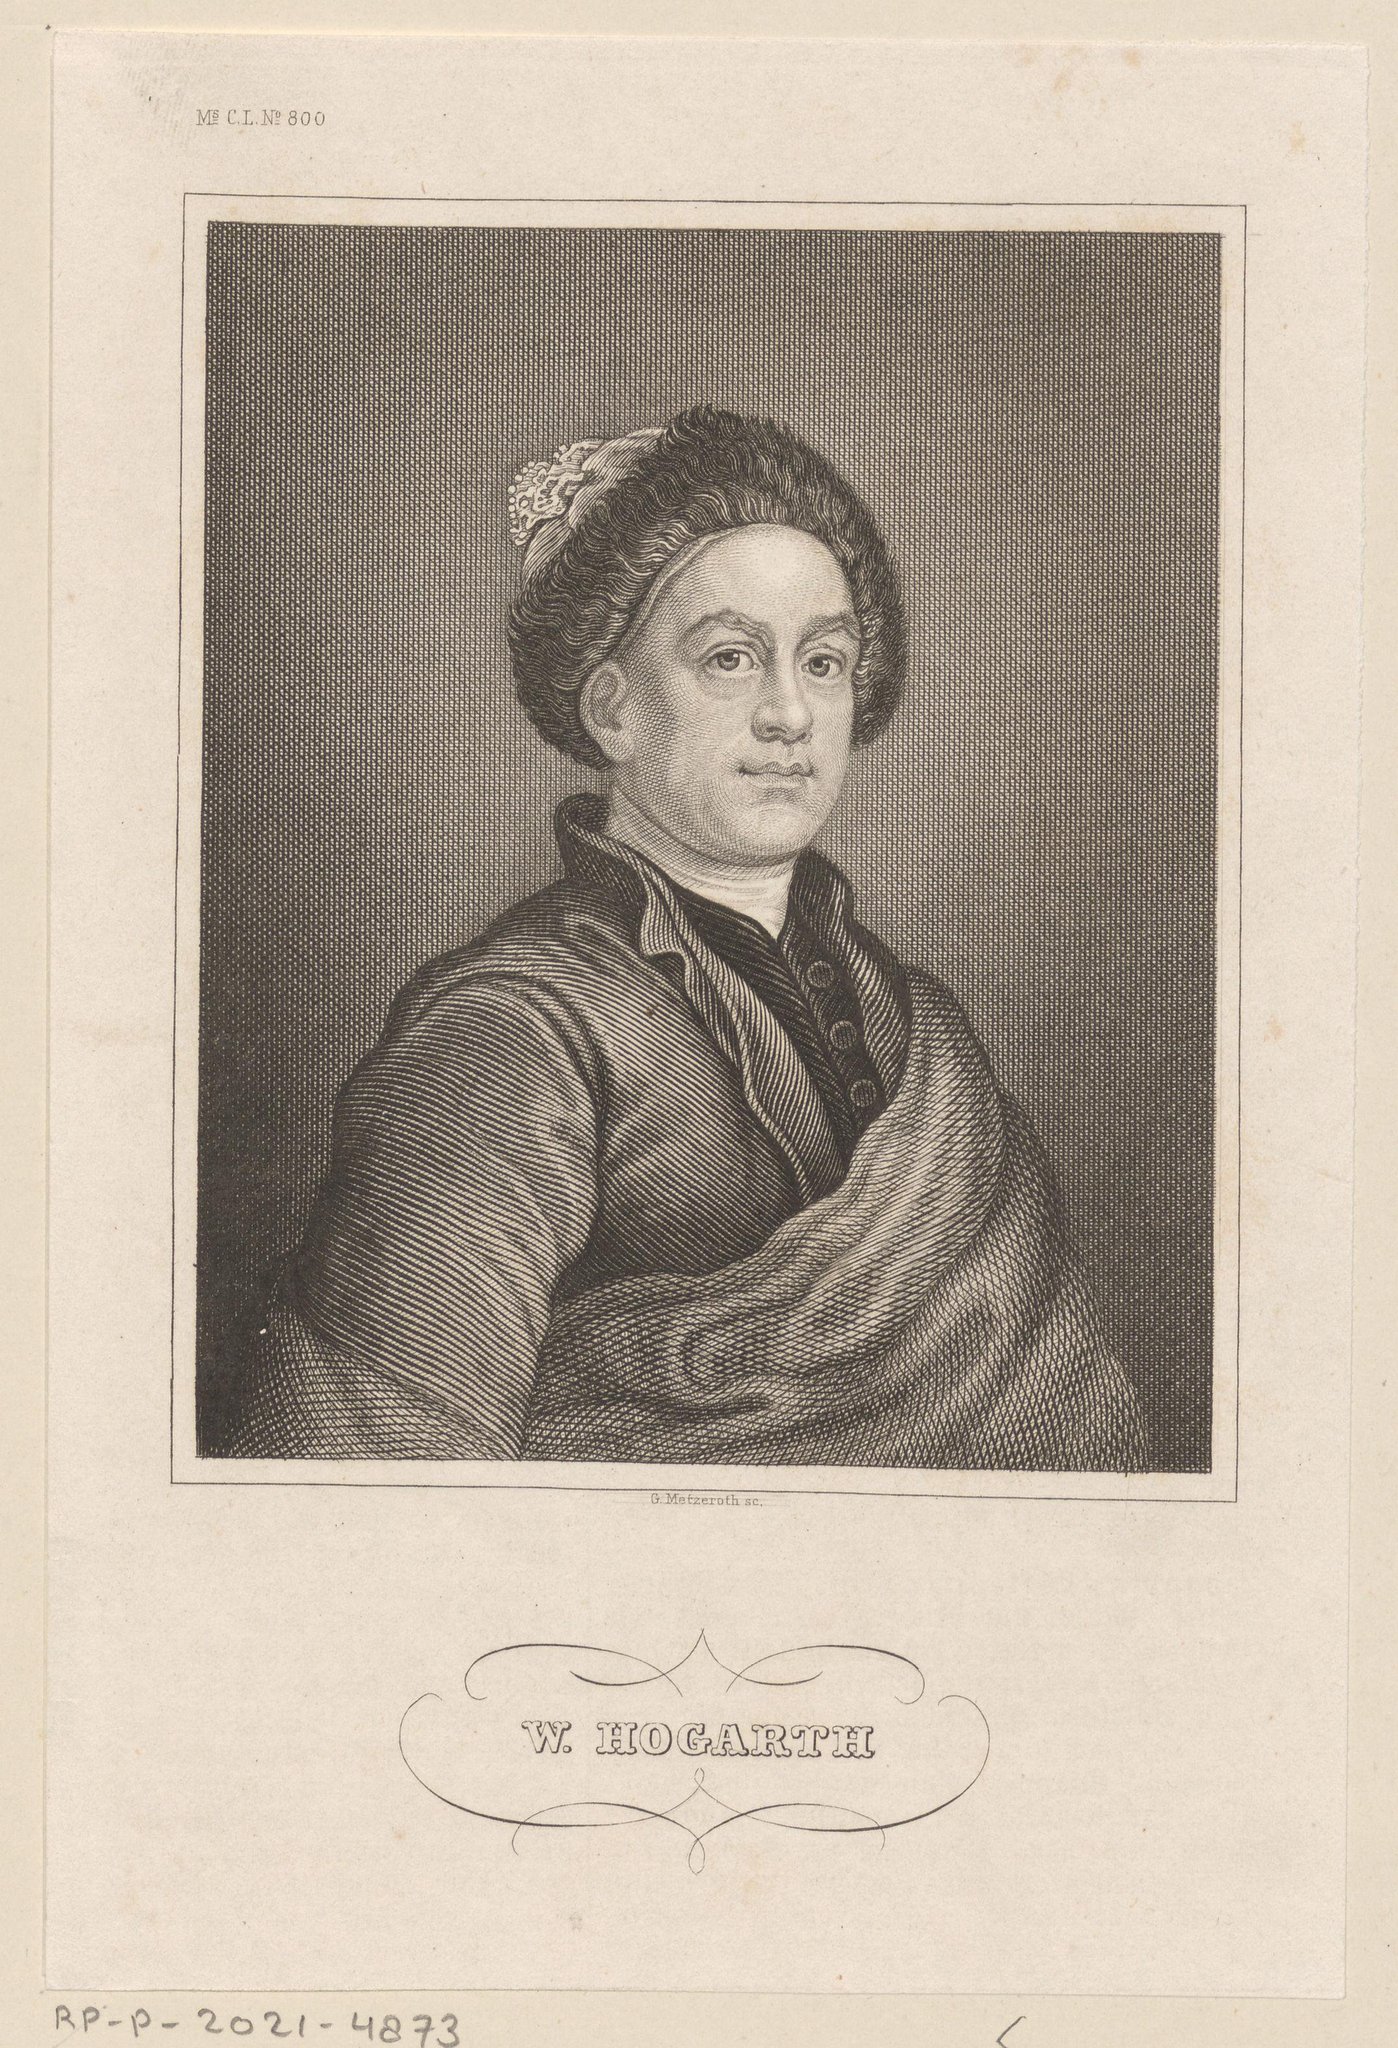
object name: print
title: Portret van William Hogarth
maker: g. metzeroth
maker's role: print maker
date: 1840-1855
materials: paper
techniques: engraving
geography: hildburghausen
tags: london, painter, print maker, william hogarth, historical persons, portrait, self-portrait of painter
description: Prent uit: Meyer, Joseph. Das Grosse Conversations-Lexikon für die gebildeten Stände. Hildburghausen: Bibliographisches Institut, 1840-1855.